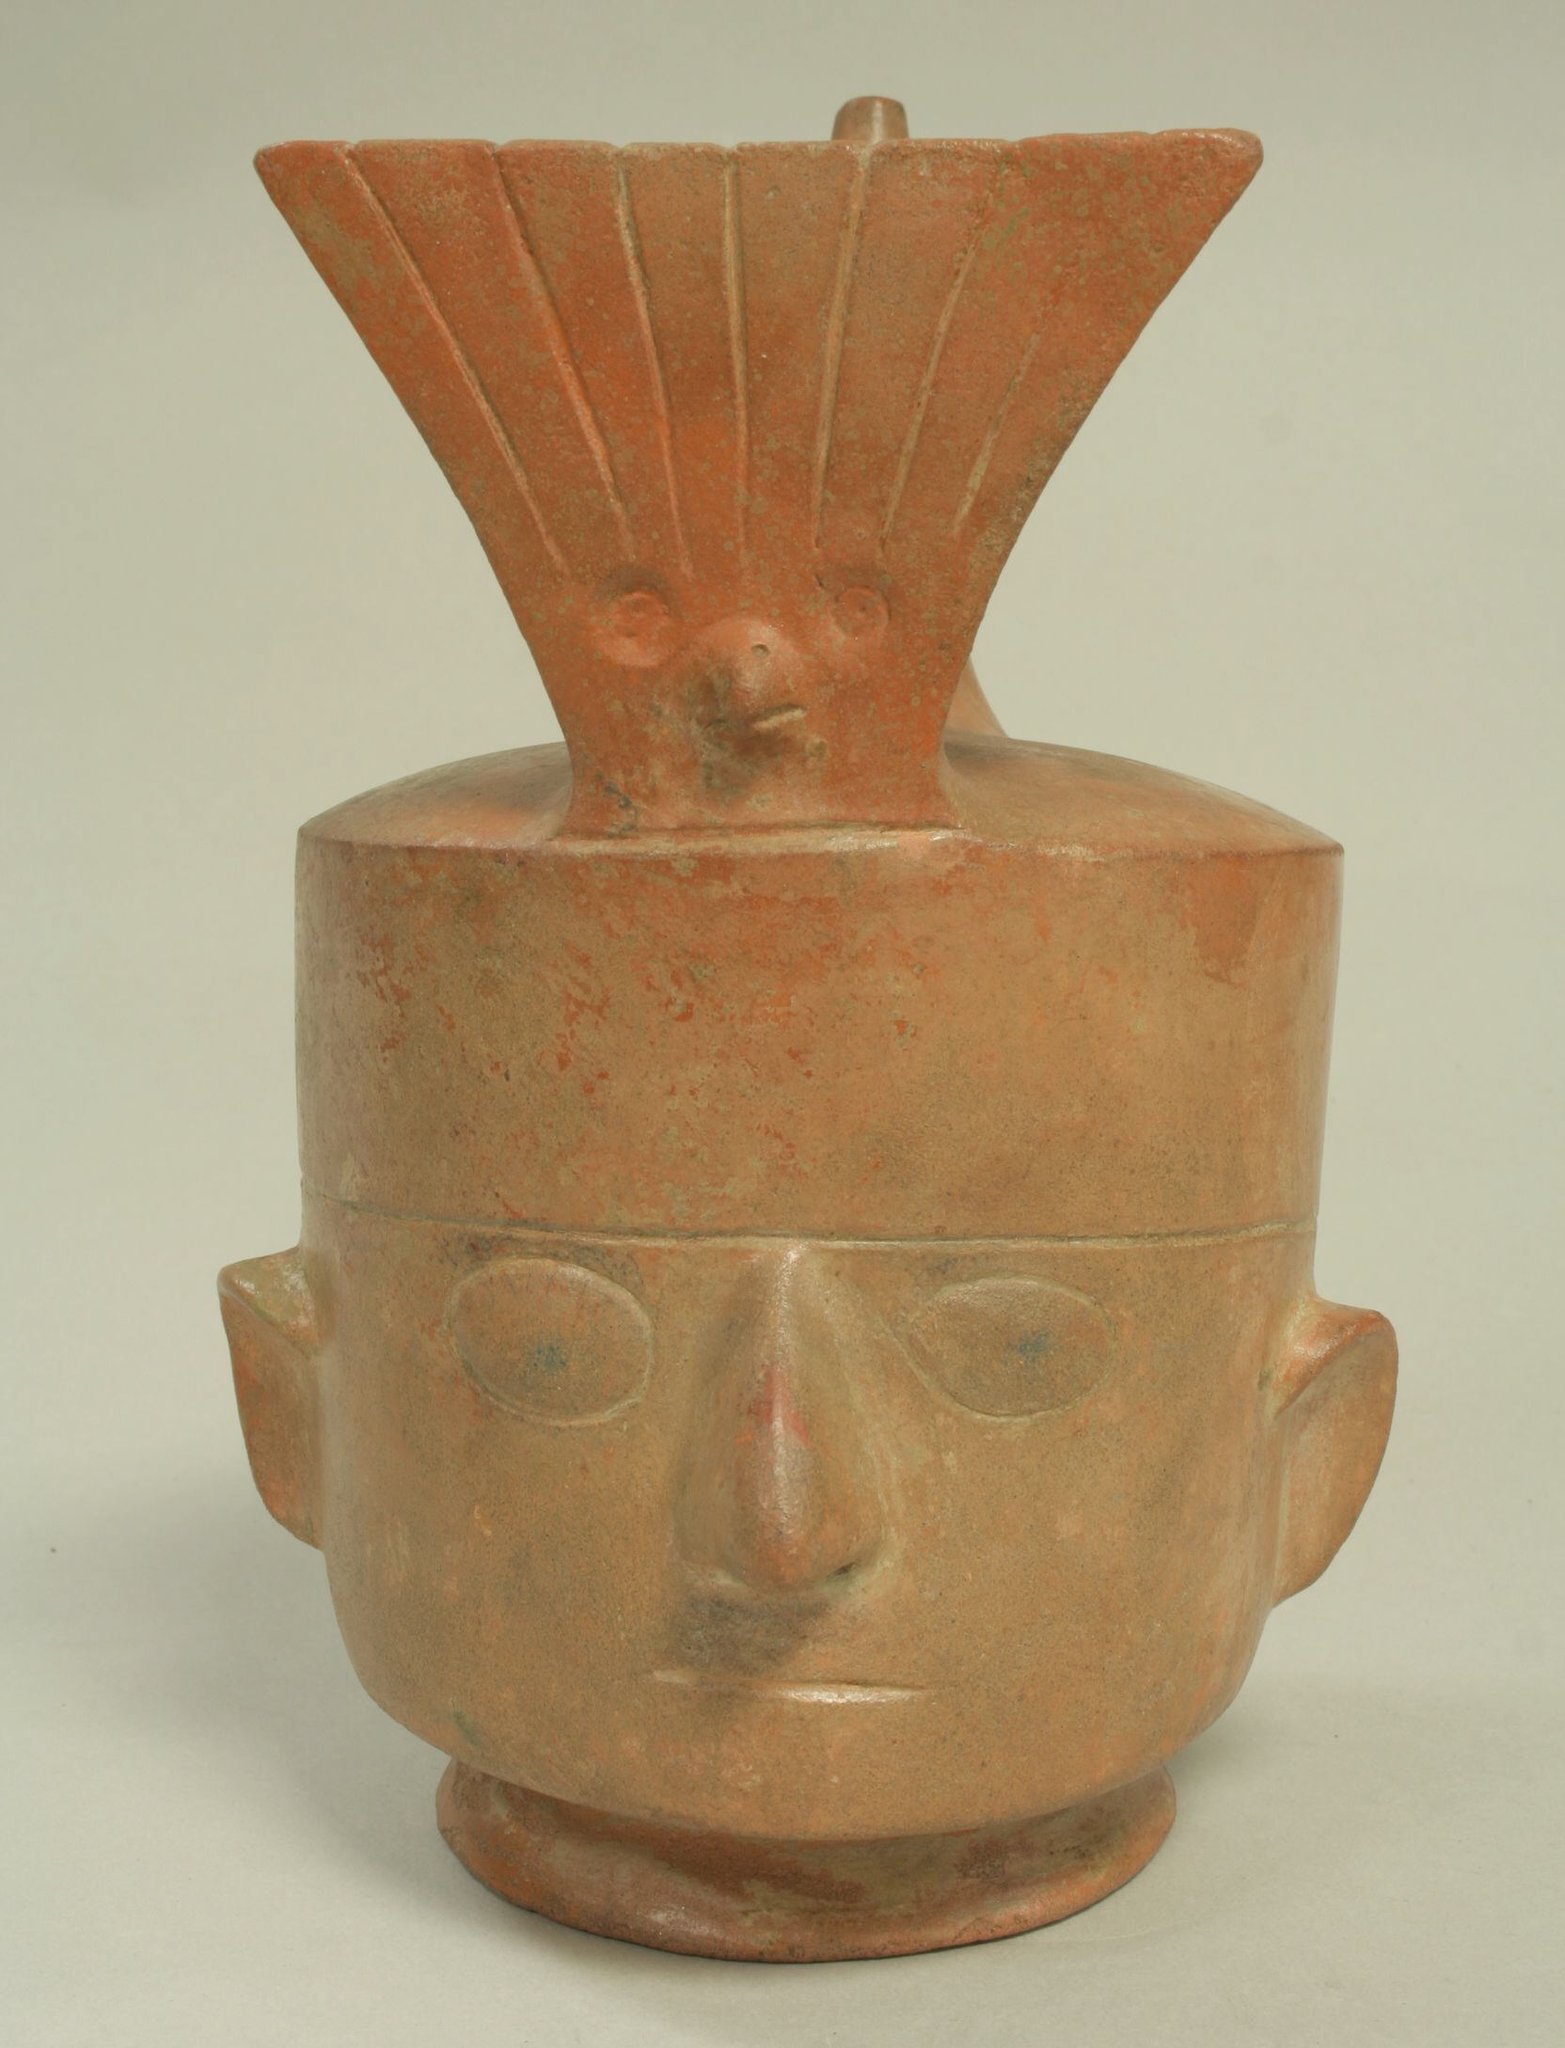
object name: bottle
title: Bridge and Spout Face Bottle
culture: north coast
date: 1501-1600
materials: ceramic, pigment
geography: peru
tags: faces